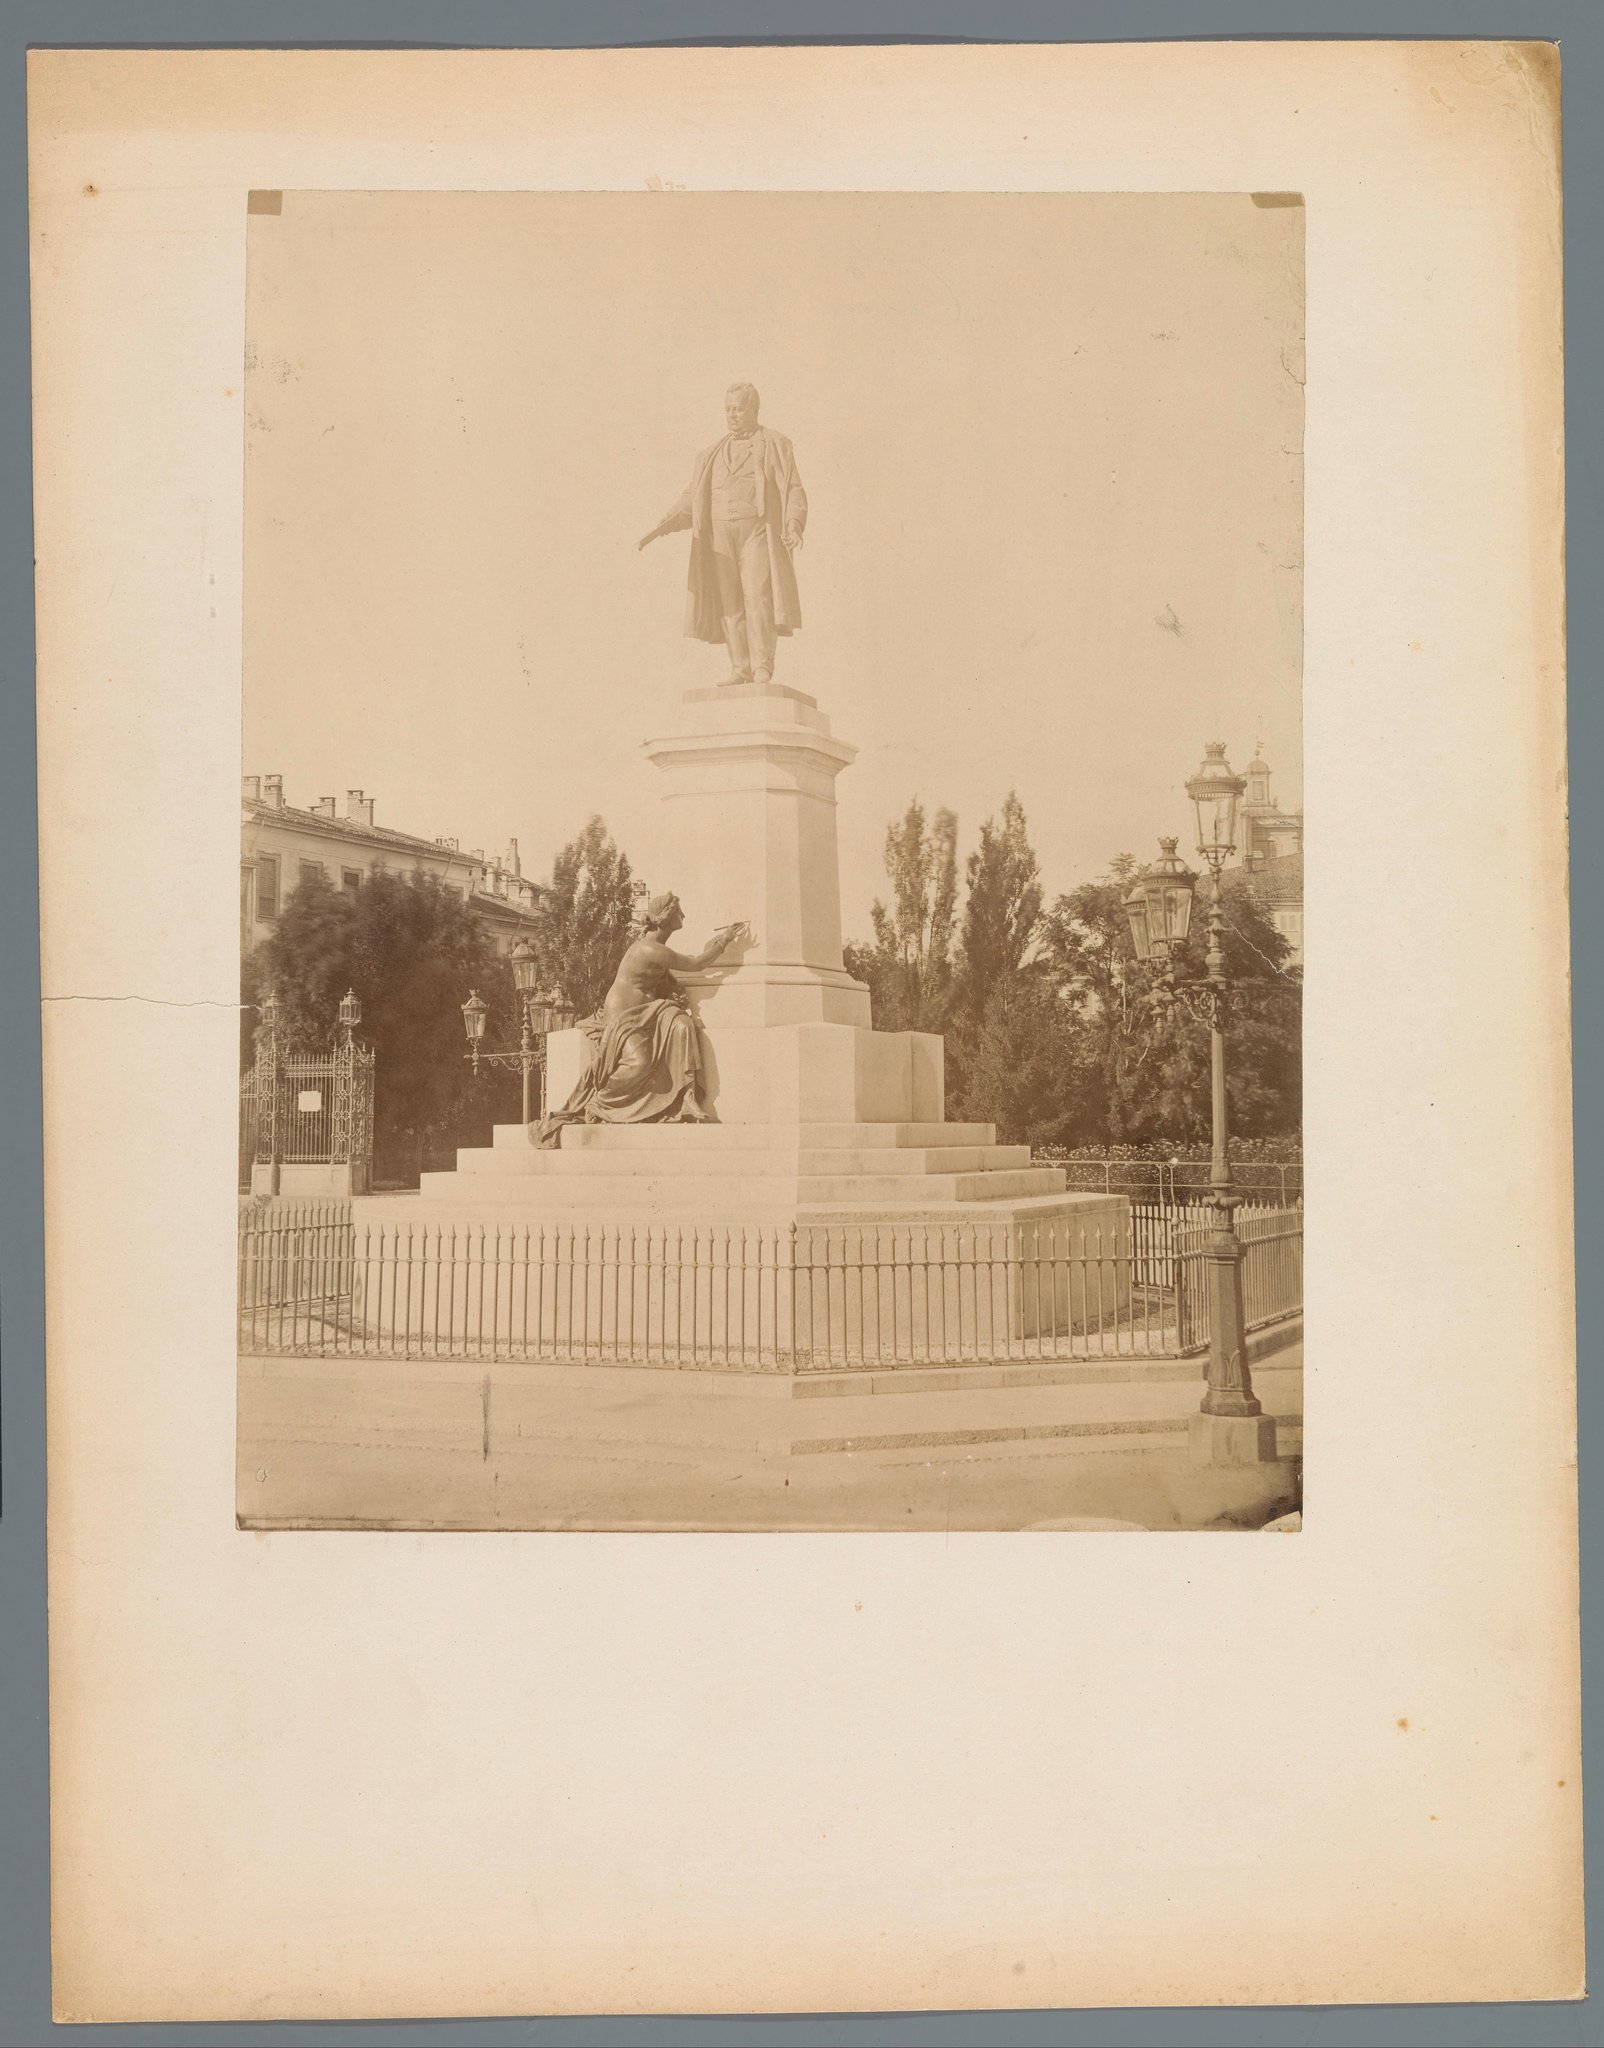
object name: photograph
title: Monument voor Camillo Benso Cavour te Milaan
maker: Anonymous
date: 1865-1900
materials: cardboard, photographic support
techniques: albumen print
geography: milan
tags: politician, woman (showing herself) undressed, quasi-nude, pedestal of a piece of sculpture (perhaps in the form of a herm), monument, statue, europe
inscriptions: collector's mark: Lugt 3937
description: Monument voor Camillo Benso Cavour op de Piazza Cavour te Milaan., vervaardigd door Odoardo Tabacchi en Antonio Tantardini.